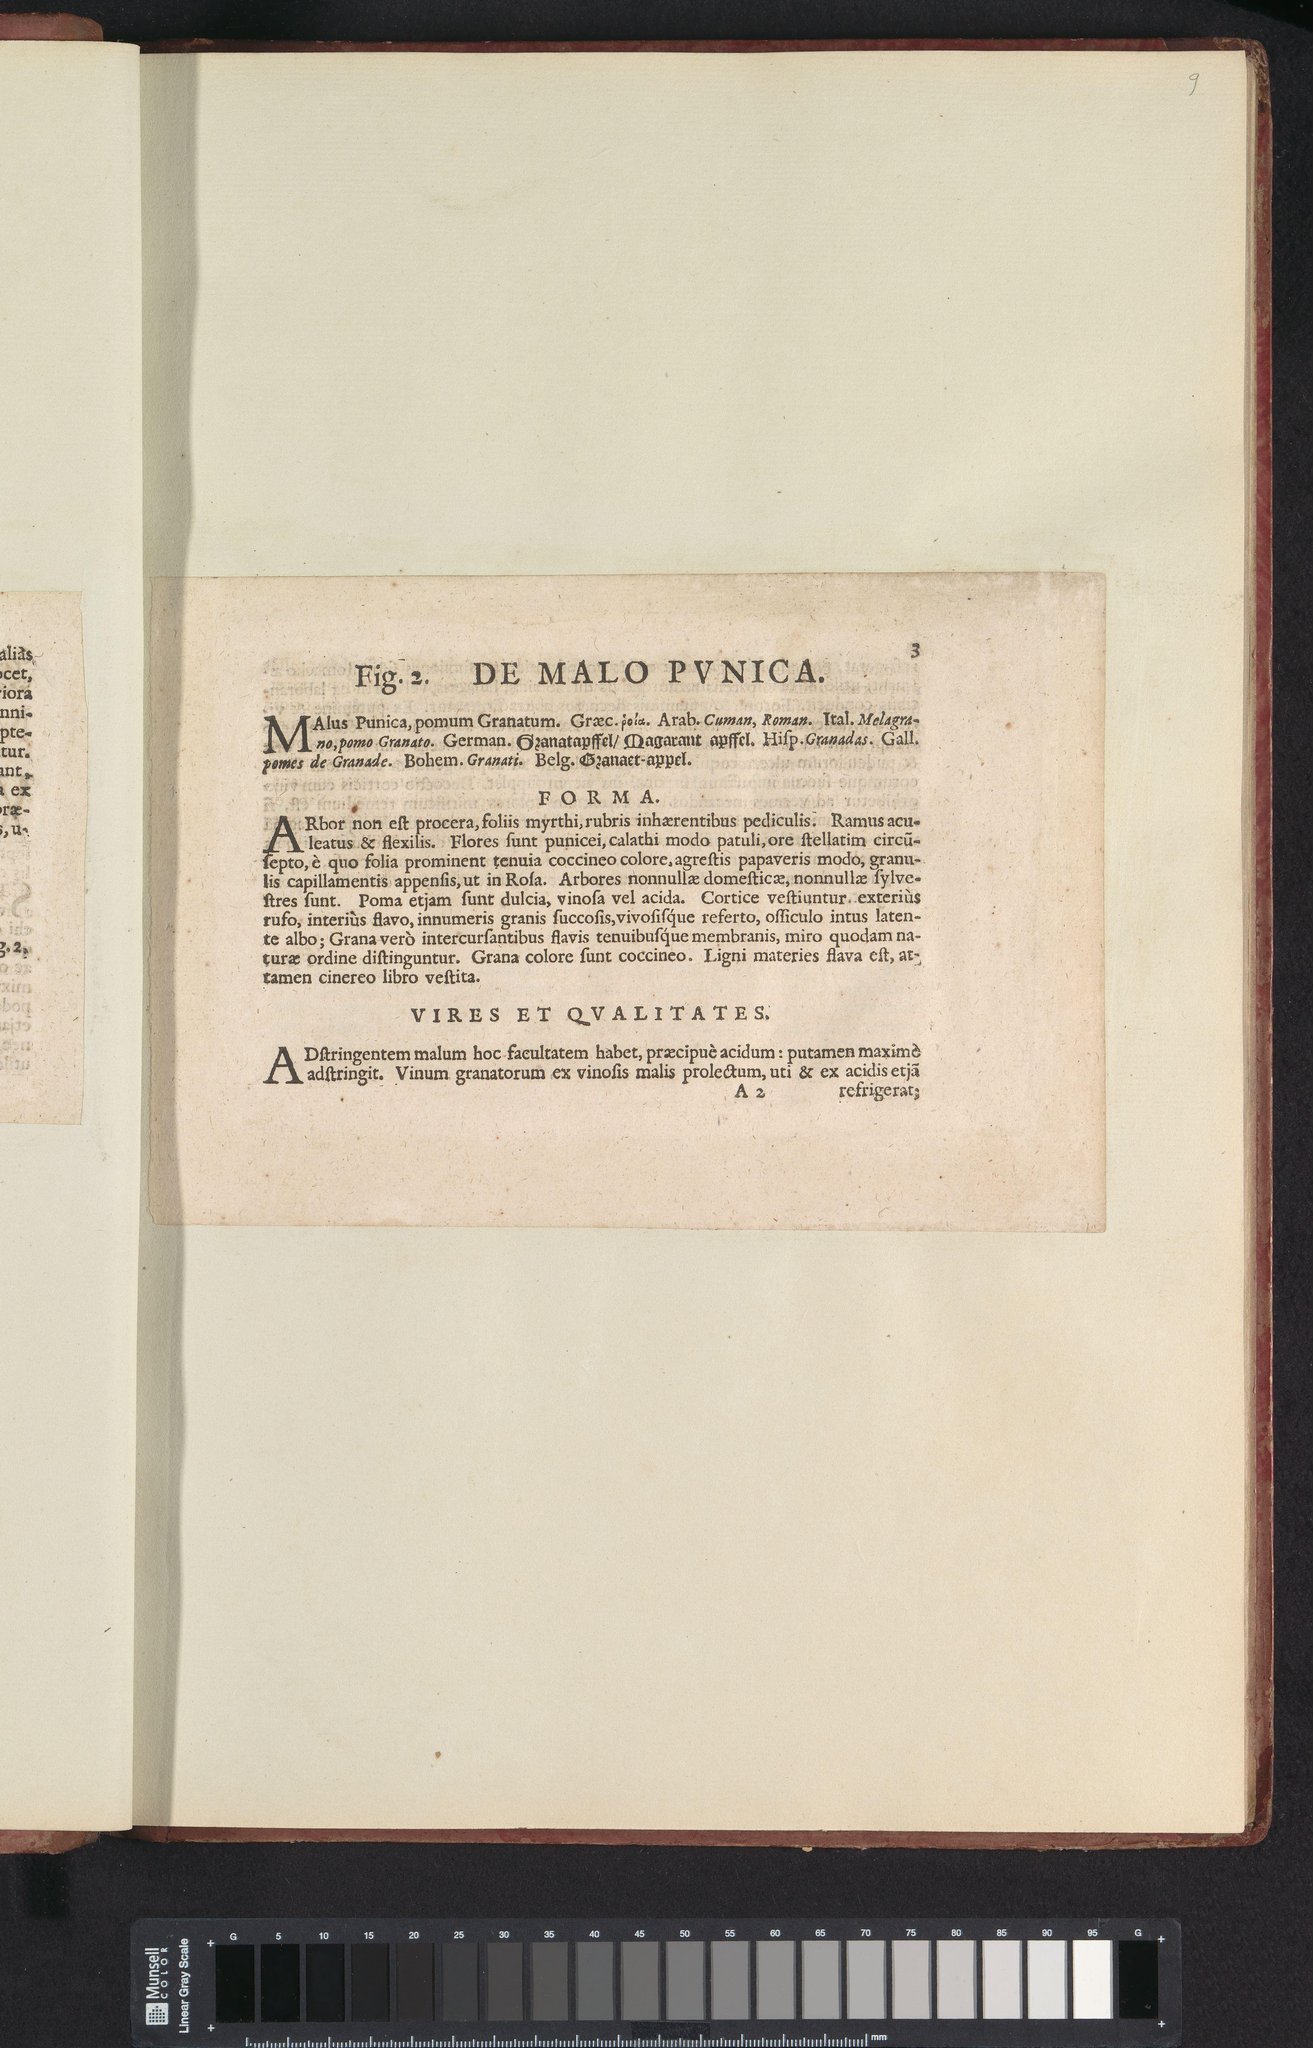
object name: text sheet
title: Fig. 2 'De Malo Pvnica' in De Boodts herbarium van 1640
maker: anselmus boëtius de boodt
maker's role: draughtsman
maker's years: 1550-1632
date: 1640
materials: ink, paper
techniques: letterpress printing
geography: bruges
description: Beschrijving bij Fig. 2 op p. 3 in: Anselmi Boëtii de Boot I.C. Brugensis & Rodolphi II. Imp. Roman. medici a cubiculis Florum, Herbarum, ac fructuum selectiorum icones, & vires pleraeque hactenus ignotæ. Onderdeel van het album met bladen en platen uit De Boodts herbarium van 1640. Het twaalfde van twaalf albums met aquarellen van dieren, vogels en planten bekend rond 1600, gemaakt in opdracht van keizer Rudolf II.